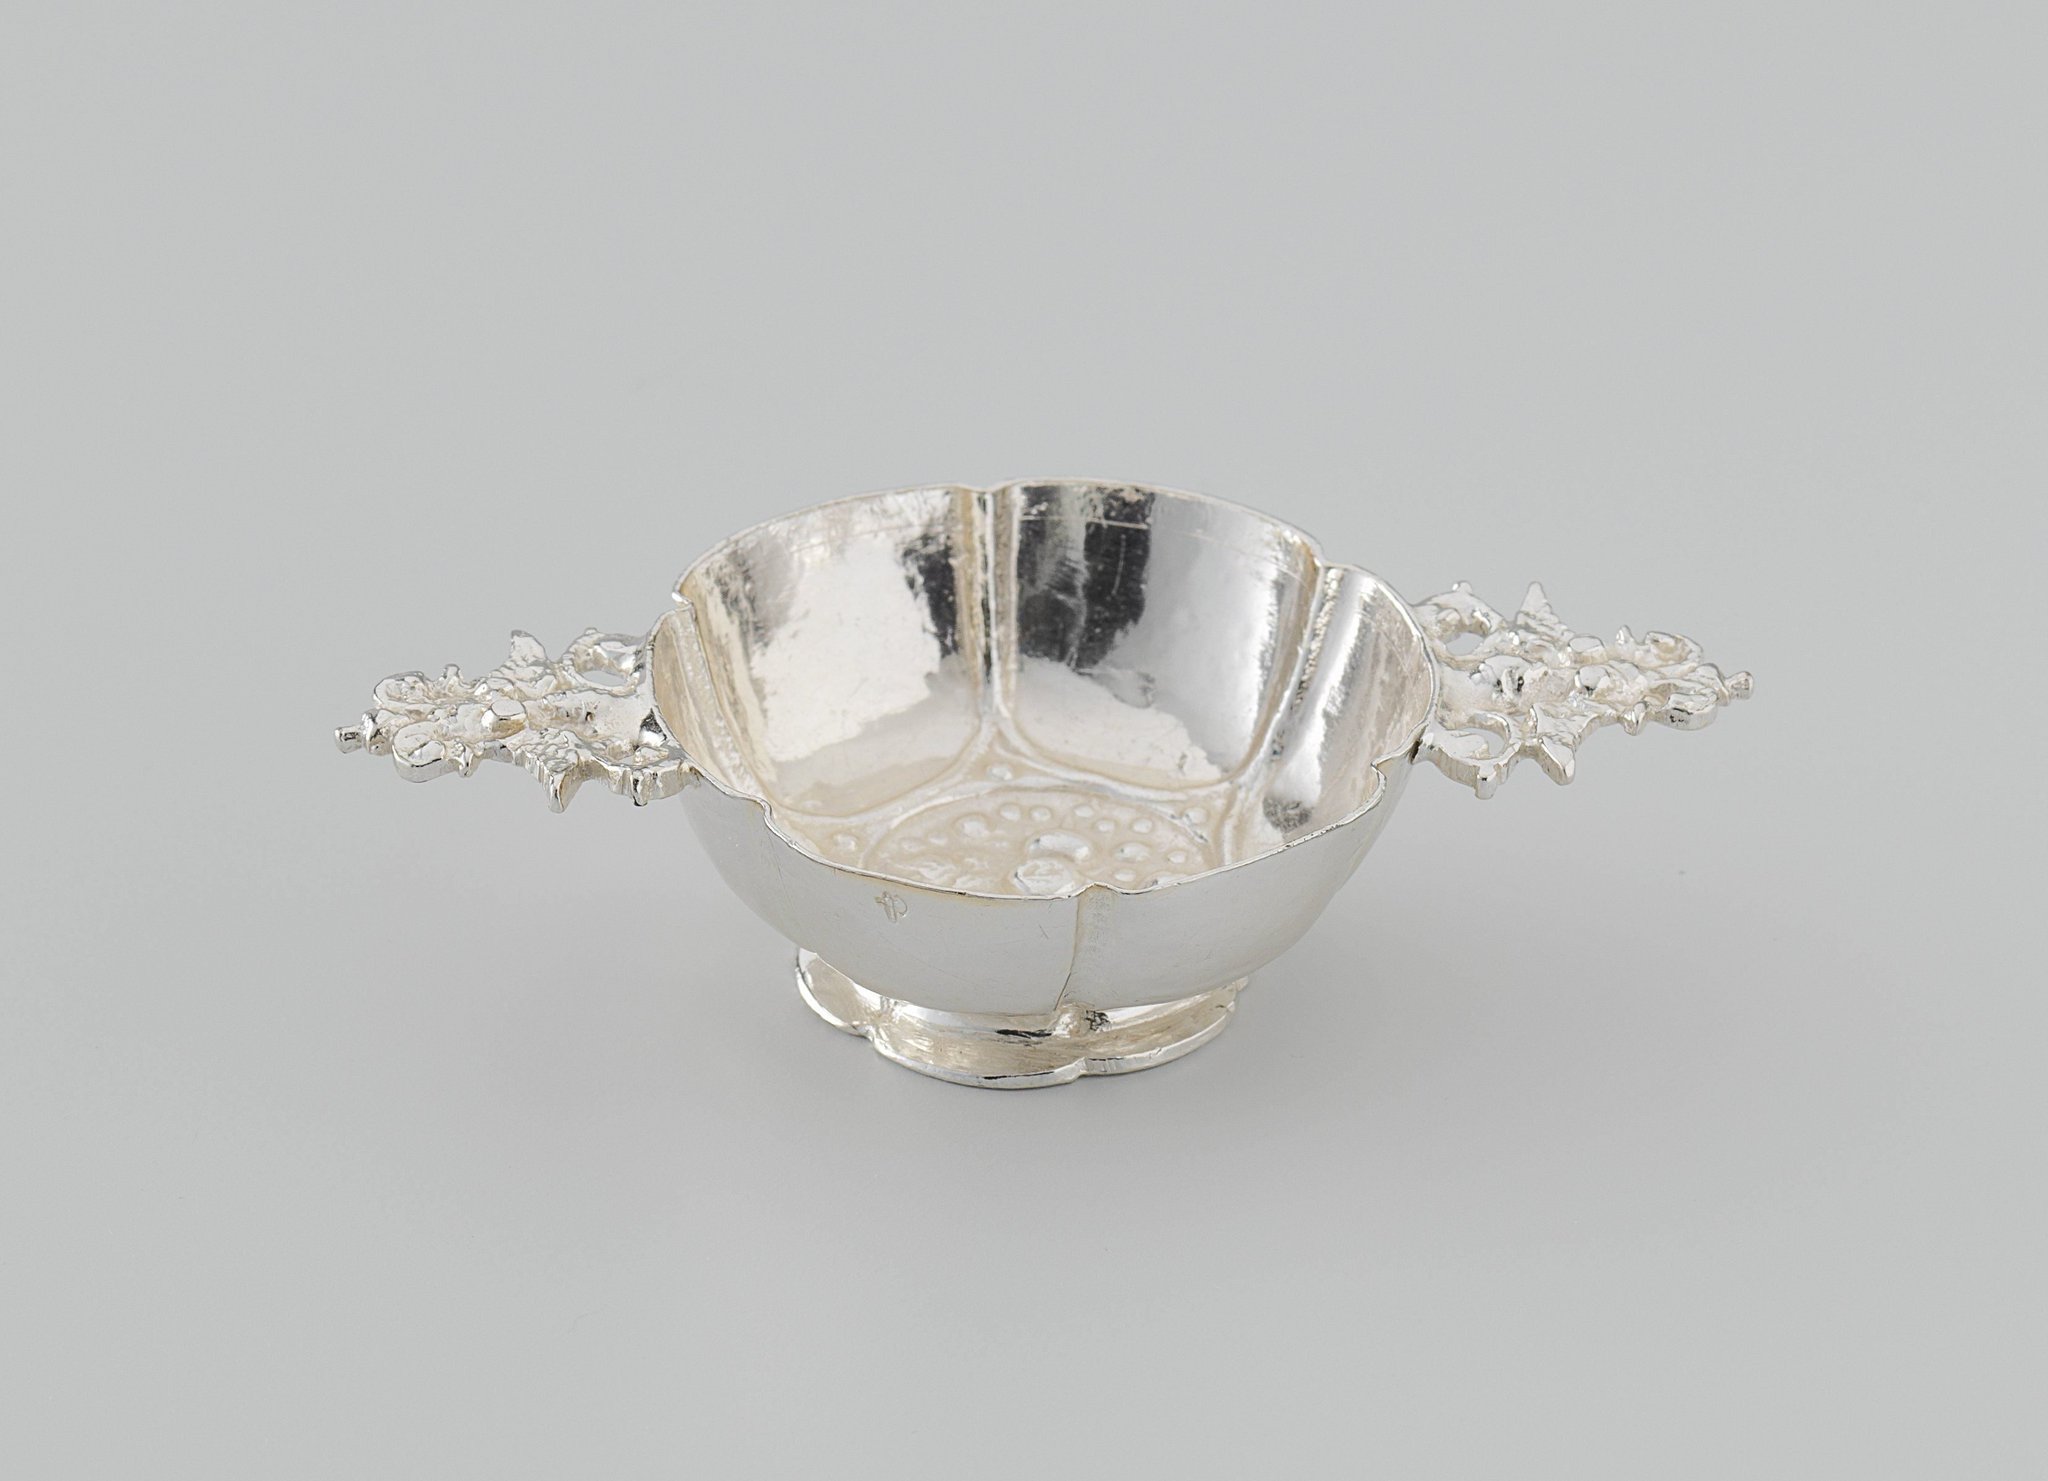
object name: miniature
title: Papkom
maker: Anonymous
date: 1600-1700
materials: silver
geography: netherlands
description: Ronde papkom op een voet met platte horizontale oren. De kom is door insnoeringen zeslobbig. De twee oren zijn plat, horizontaal en opengewerkt. De voet is gelobd en loopt wijd uit naar beneden. De bodem aan de binnenkant is gedecoreerd met een zespuntige ster. De kom is gemerkt met een bijltje.